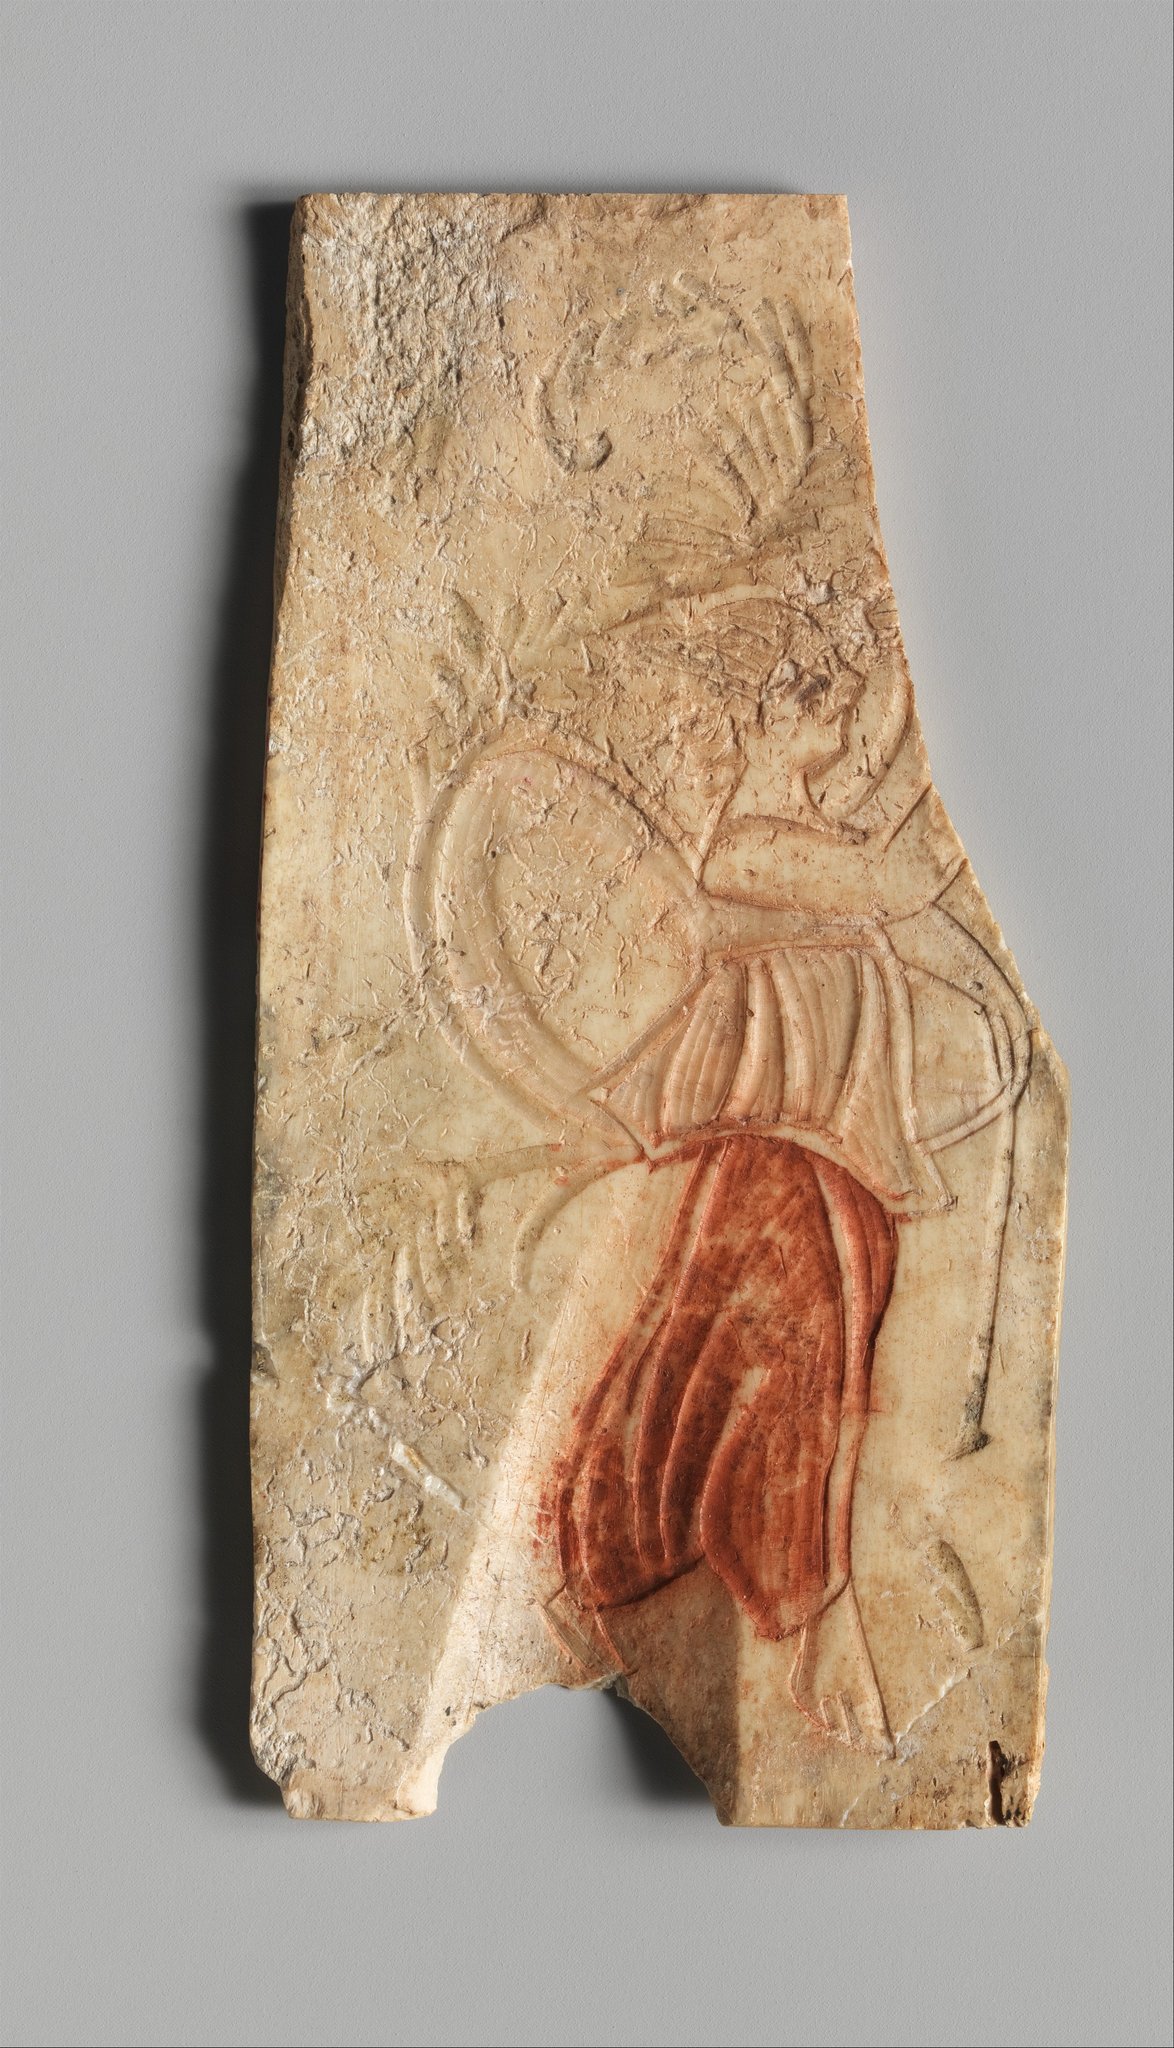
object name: casket plaque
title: Plaque from a Casket with a Dancing Woman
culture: coptic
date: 301-500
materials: bone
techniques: polychromy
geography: egypt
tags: dancing